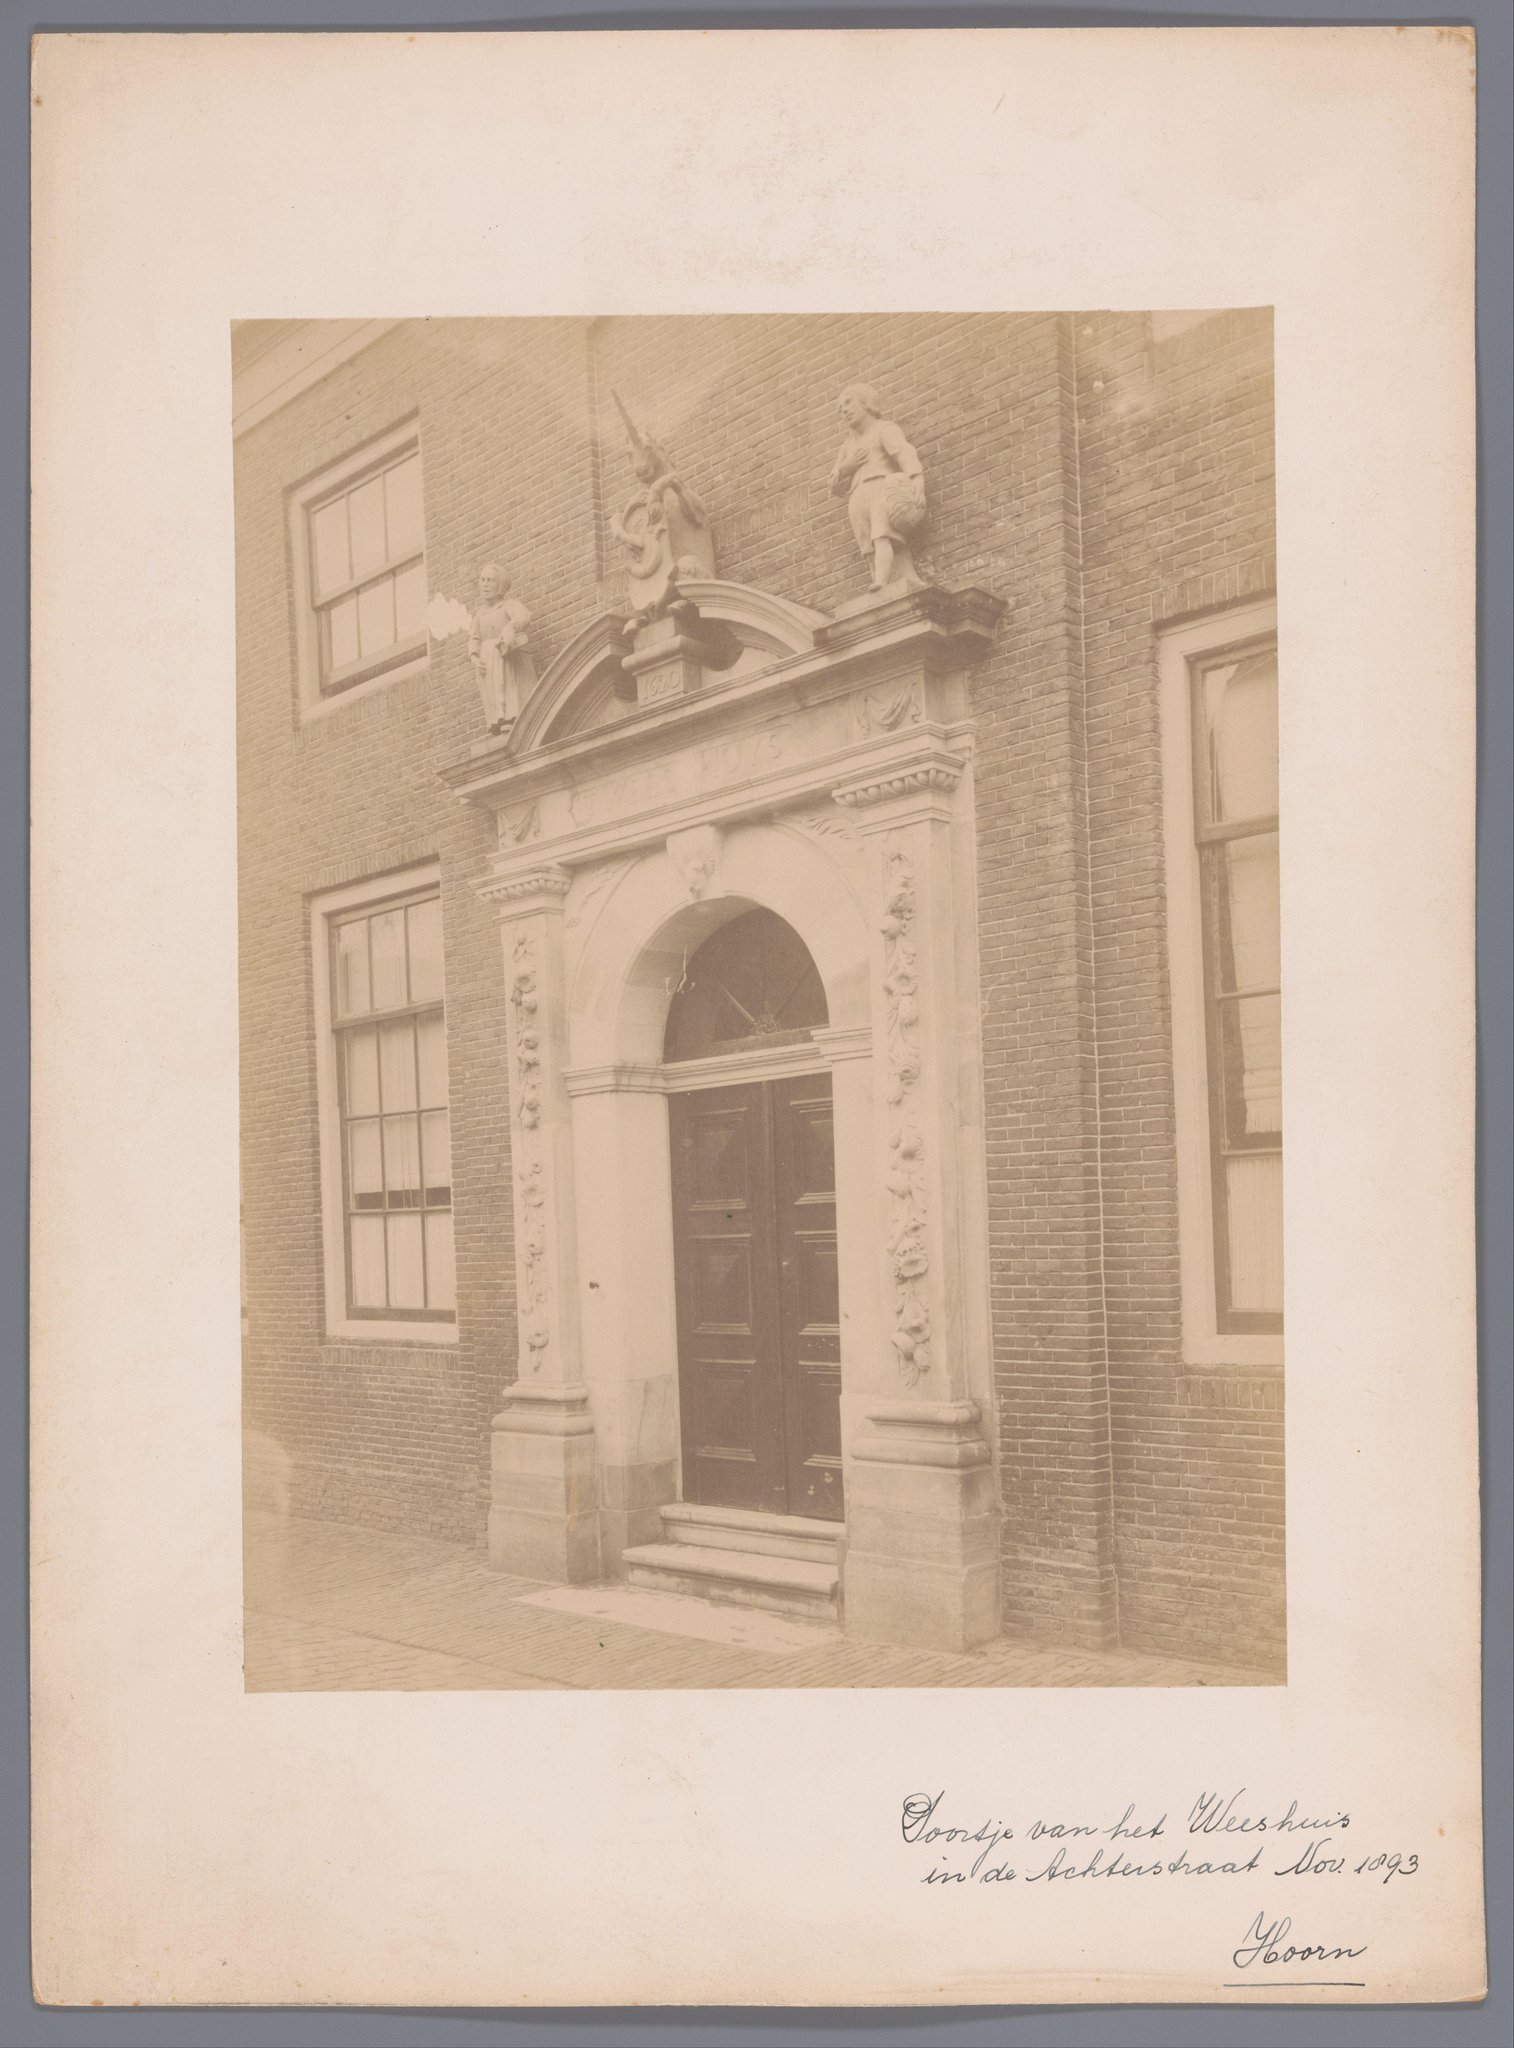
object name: photograph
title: Poort van het Weeshuis op Achterstraat 4-6 te Hoorn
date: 1893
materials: cardboard, photographic support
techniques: albumen print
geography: achterstraat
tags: gate, entrance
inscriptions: annotation: ‘Hoorn (N.H.)/ Poortje van het Weeshuis in de Achterstraat/ Nov. 1893’, annotation: ‘Poortje van het Weeshuis in de Achterstraat Nov. 1893/ Hoorn’